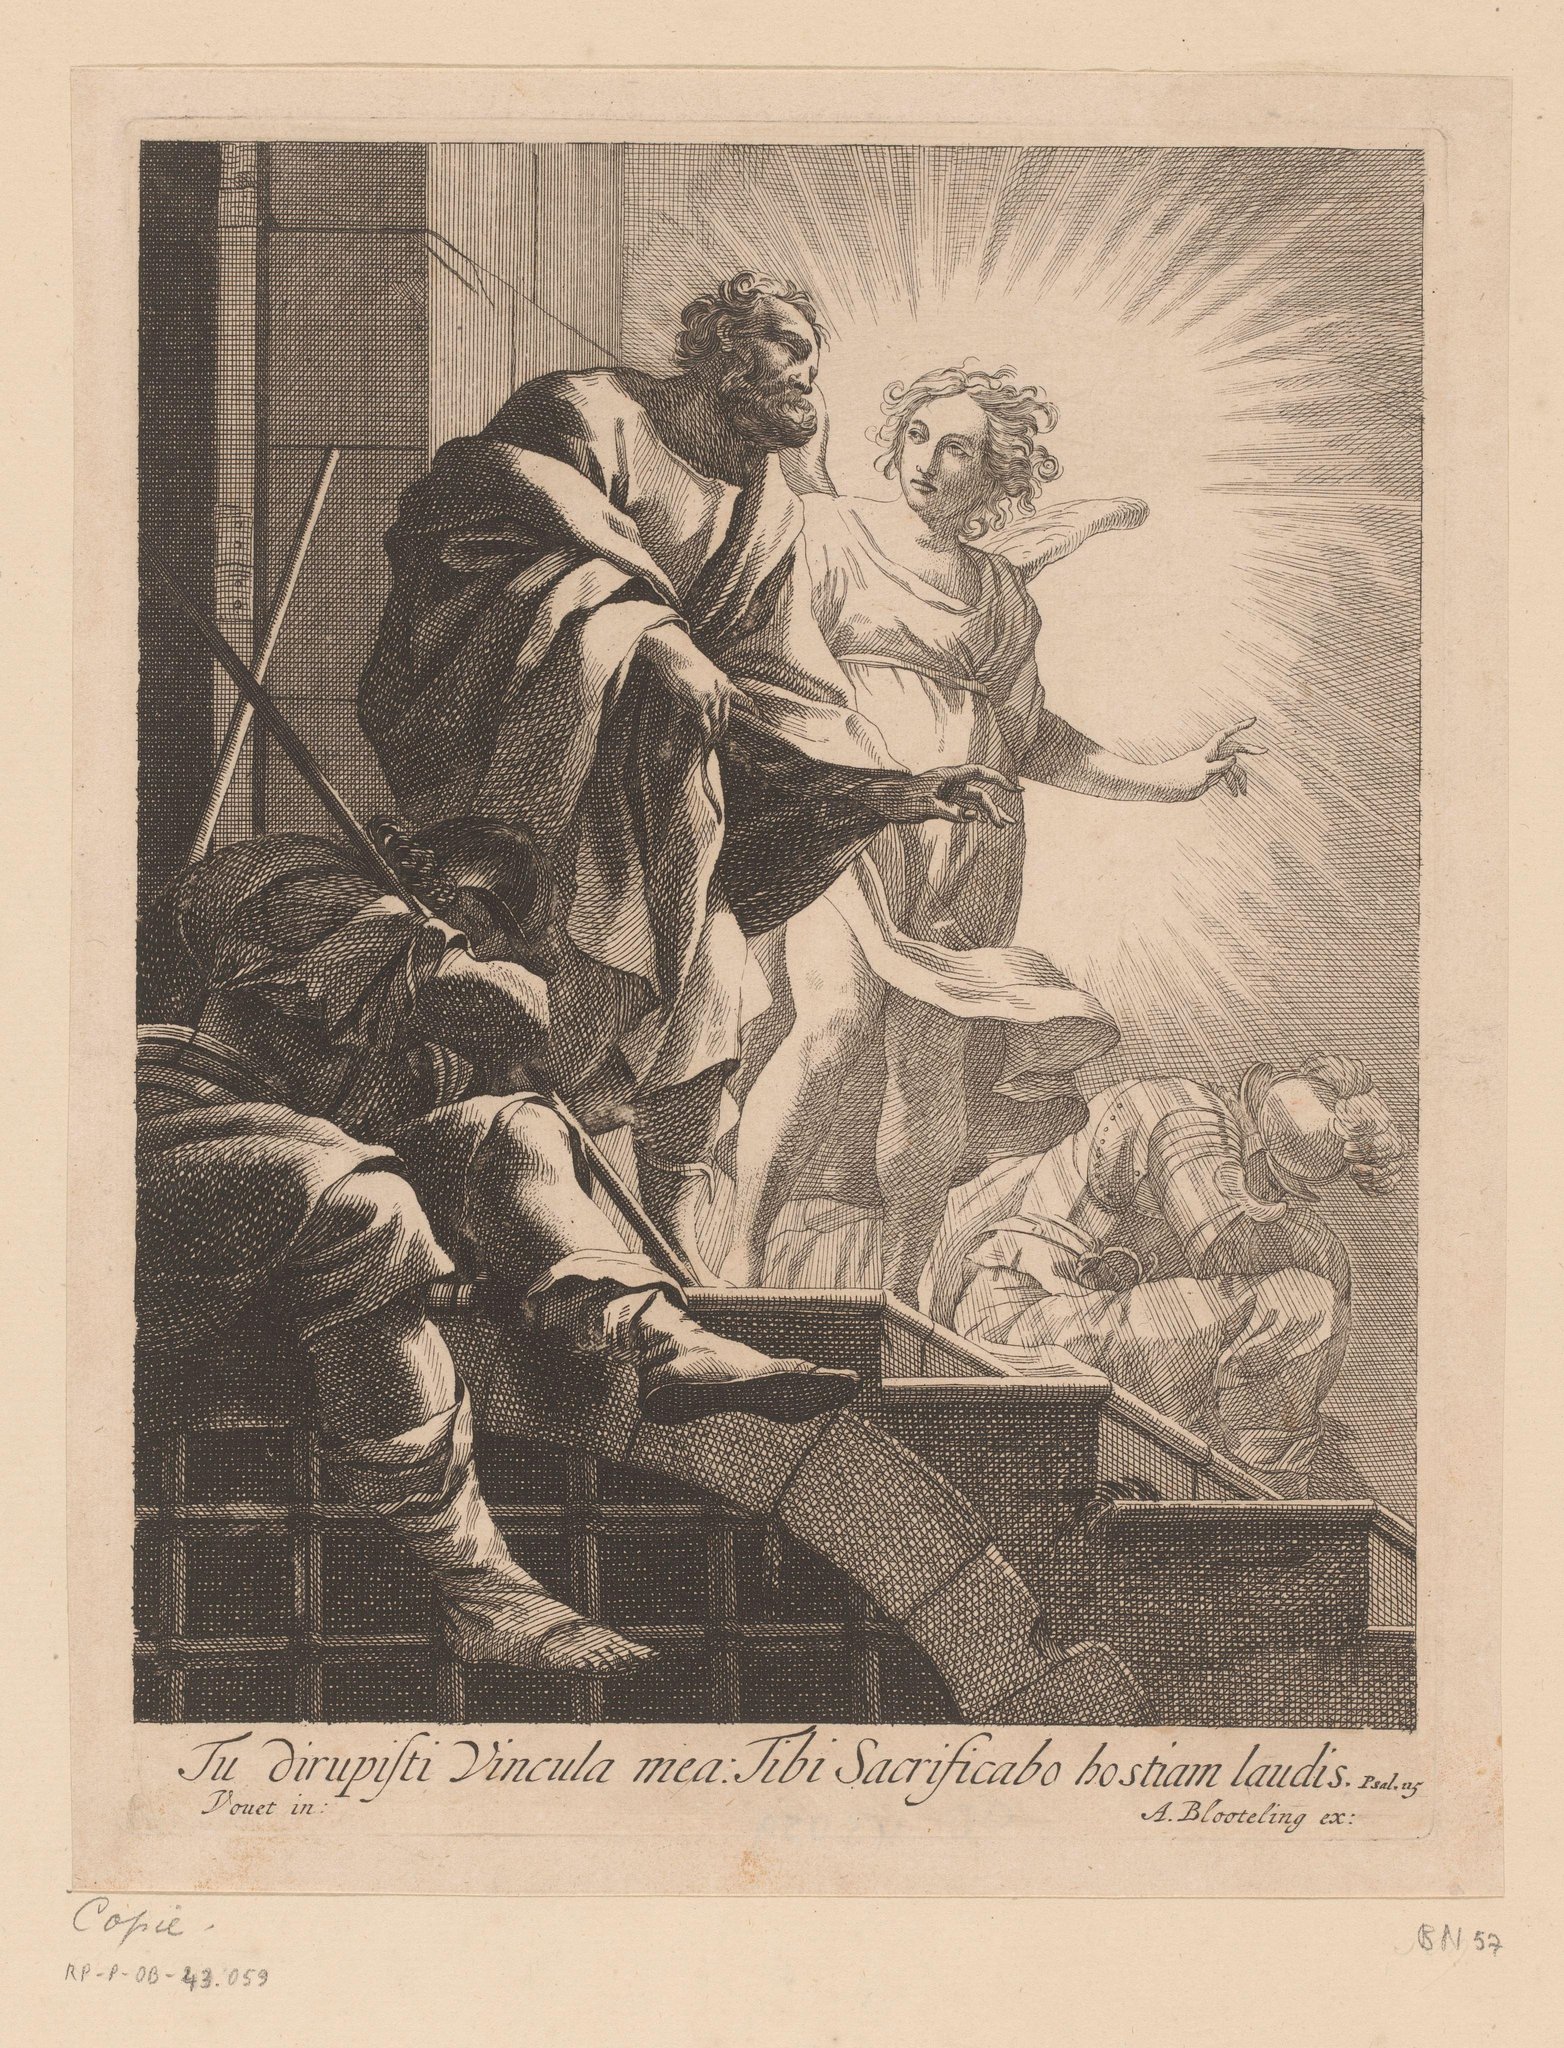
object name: print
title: Bevrijding van Petrus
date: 1640-1665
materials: paper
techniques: engraving, etching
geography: france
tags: the angel leads peter past the sleeping guards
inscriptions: collector's mark: Lugt 240